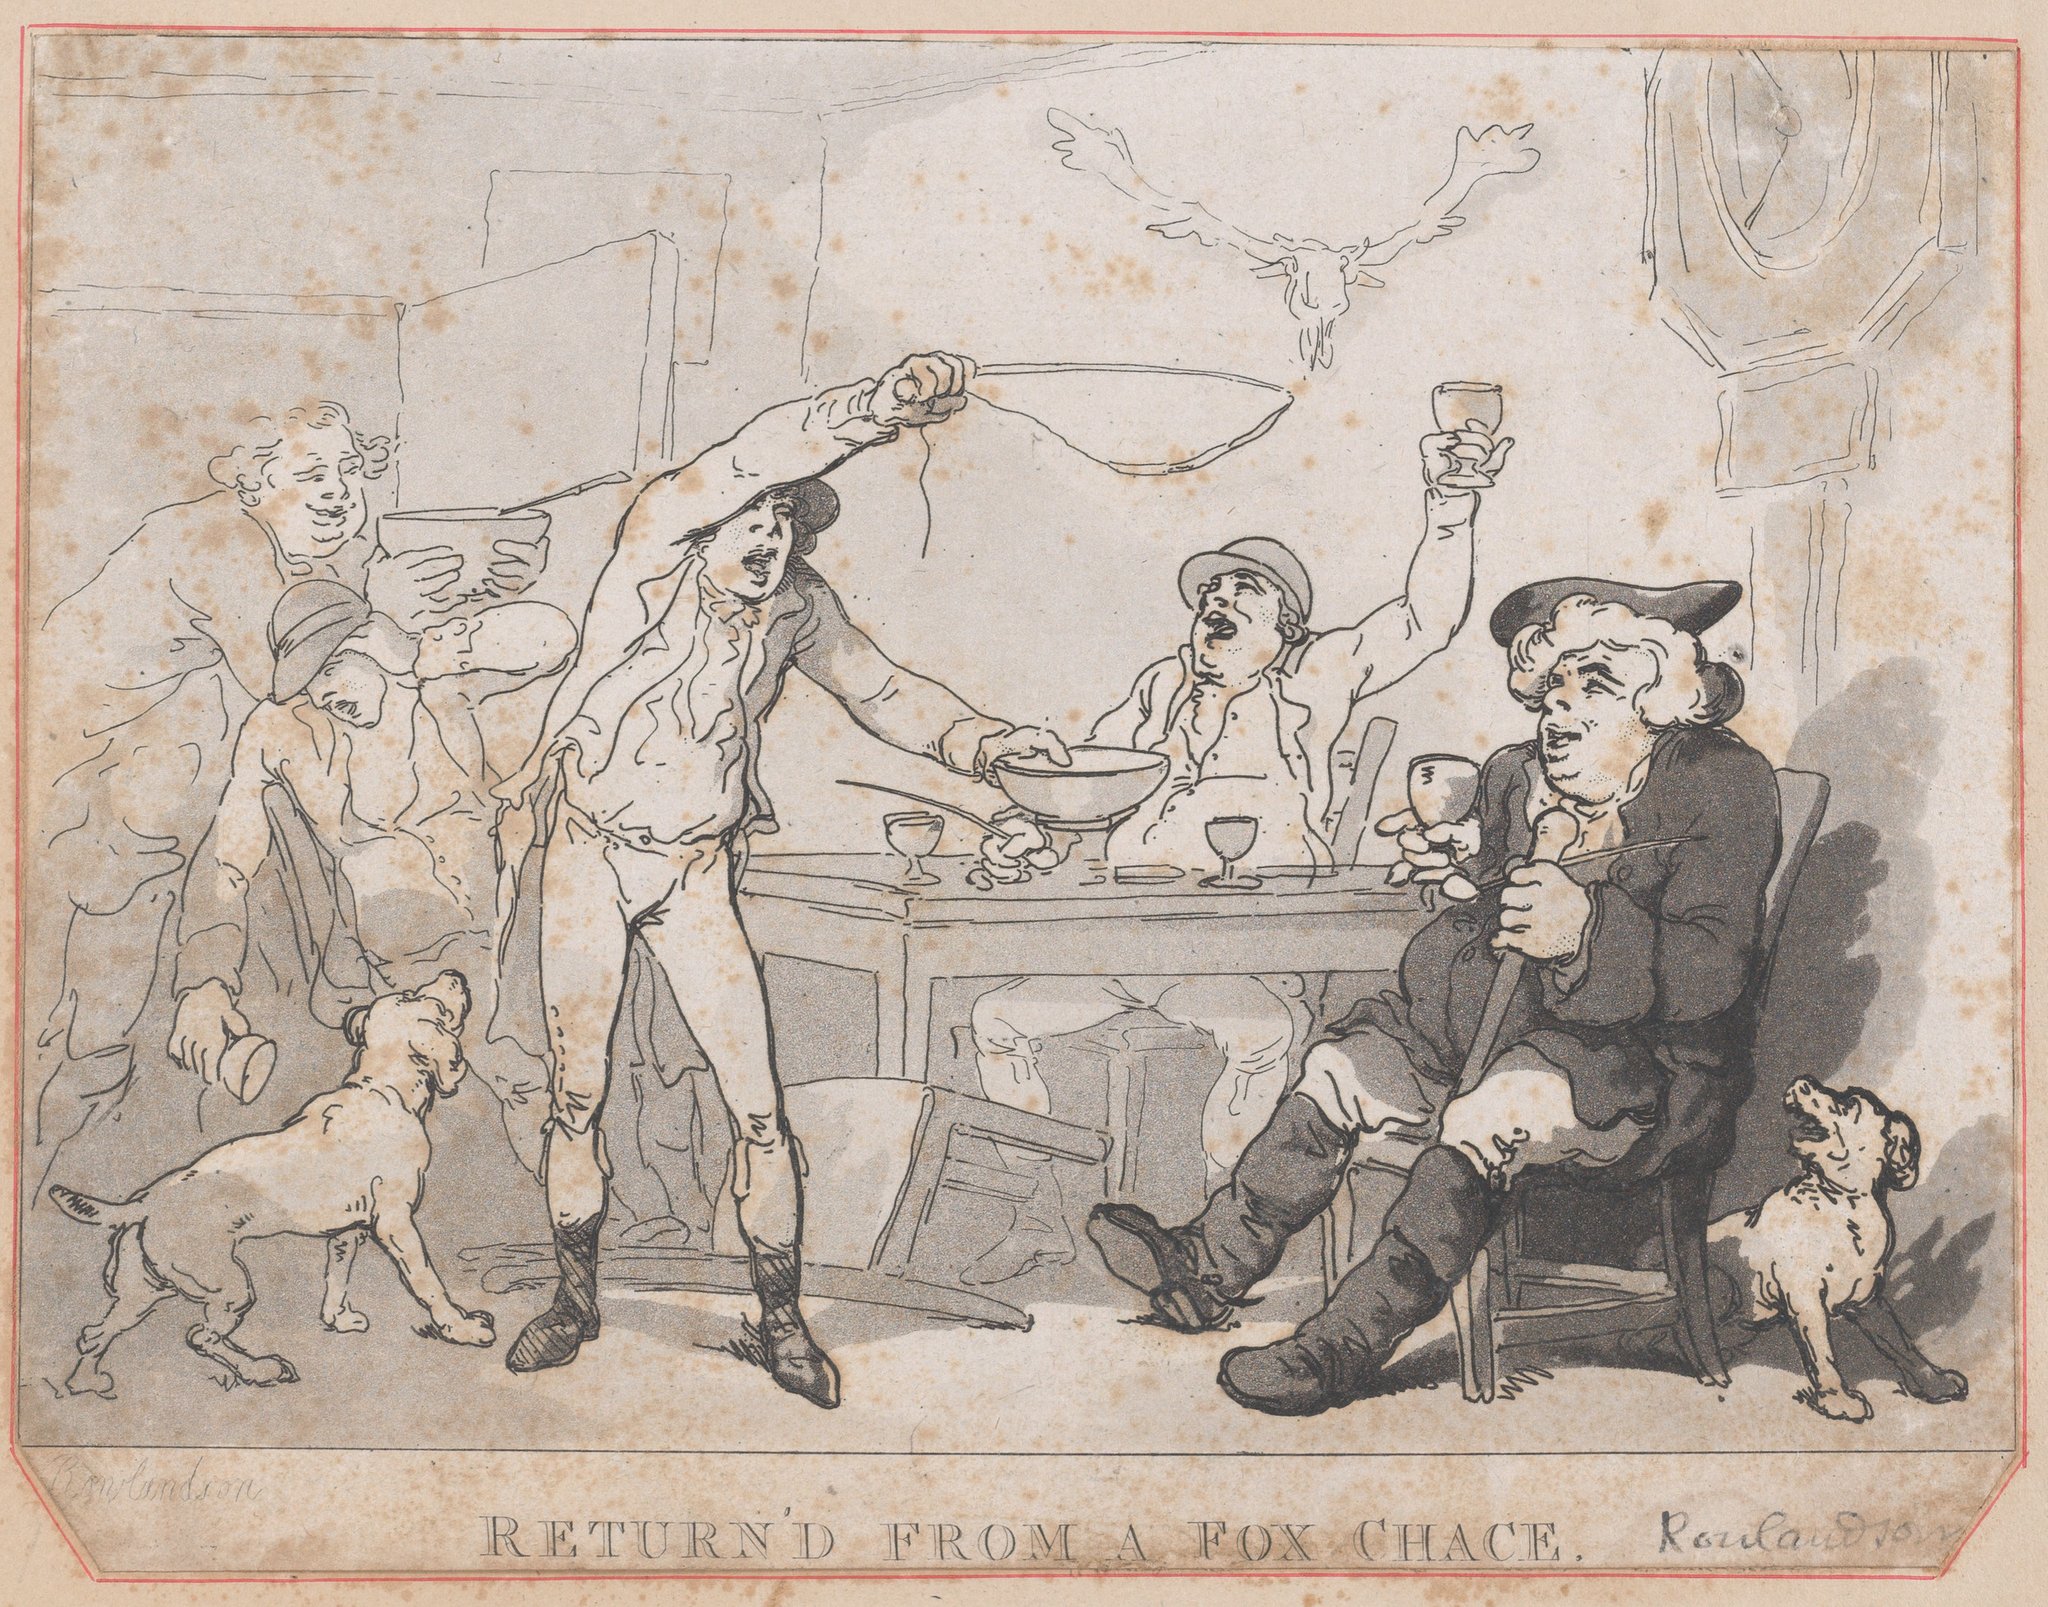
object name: print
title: Returned from a Fox Chase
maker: thomas rowlandson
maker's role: artist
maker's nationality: british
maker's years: 1757-1827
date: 1787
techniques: aquatint, etching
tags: men,dogs,drinking